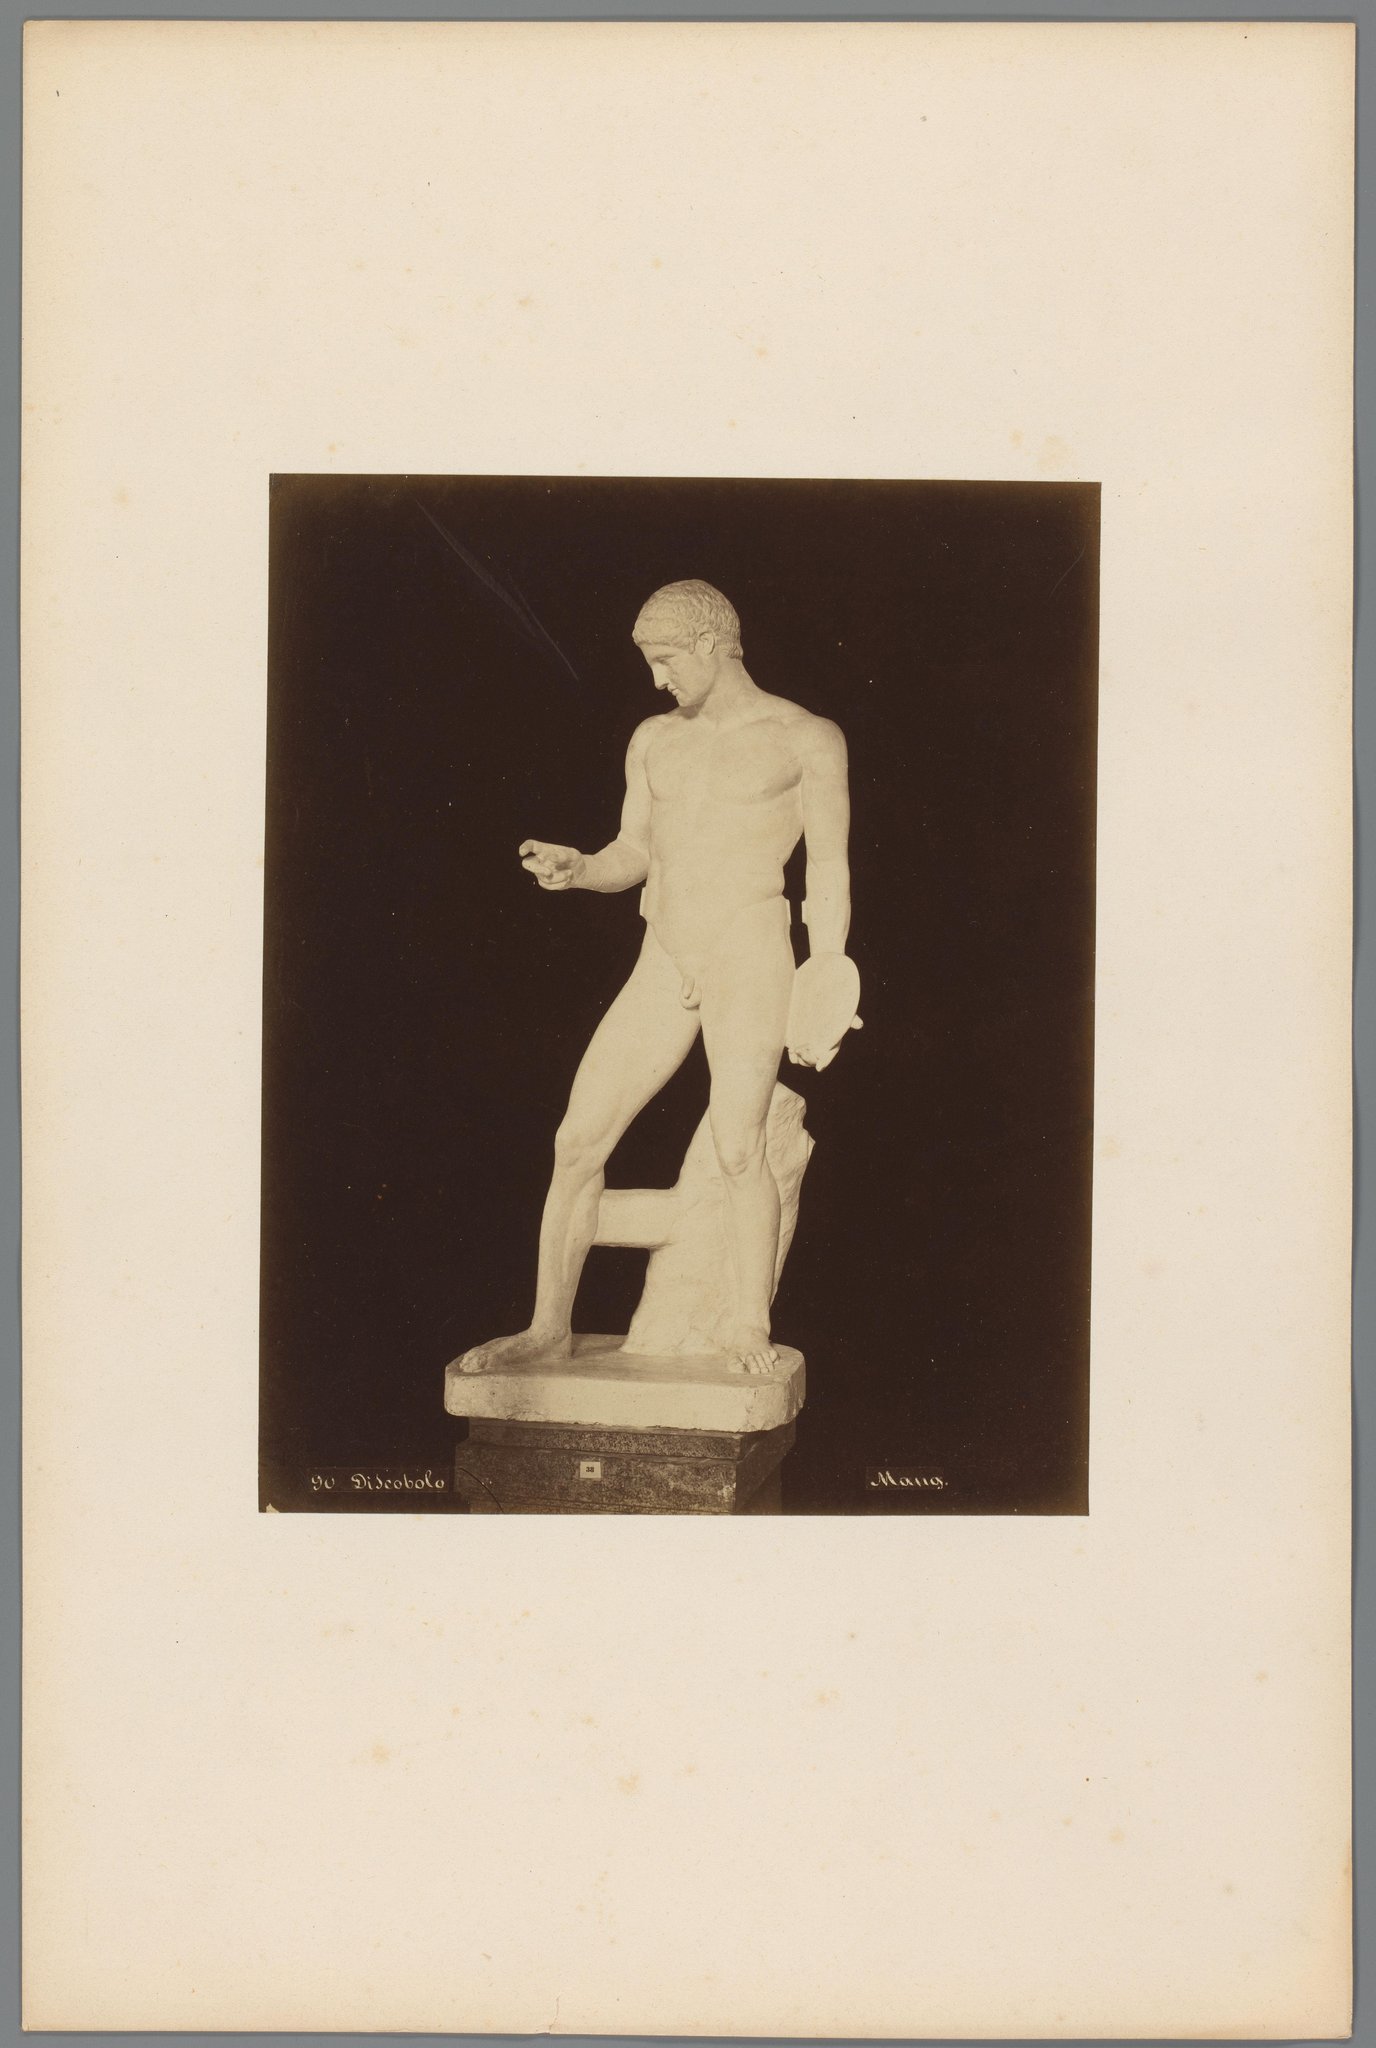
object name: photograph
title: Discobolo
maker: michèle mang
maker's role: fotograaf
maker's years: 1840-1909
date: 1863-1887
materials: cardboard, paper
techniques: albumen print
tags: discus-throwing, piece of sculpture, reproduction of a piece of sculpture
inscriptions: number: ‘90’